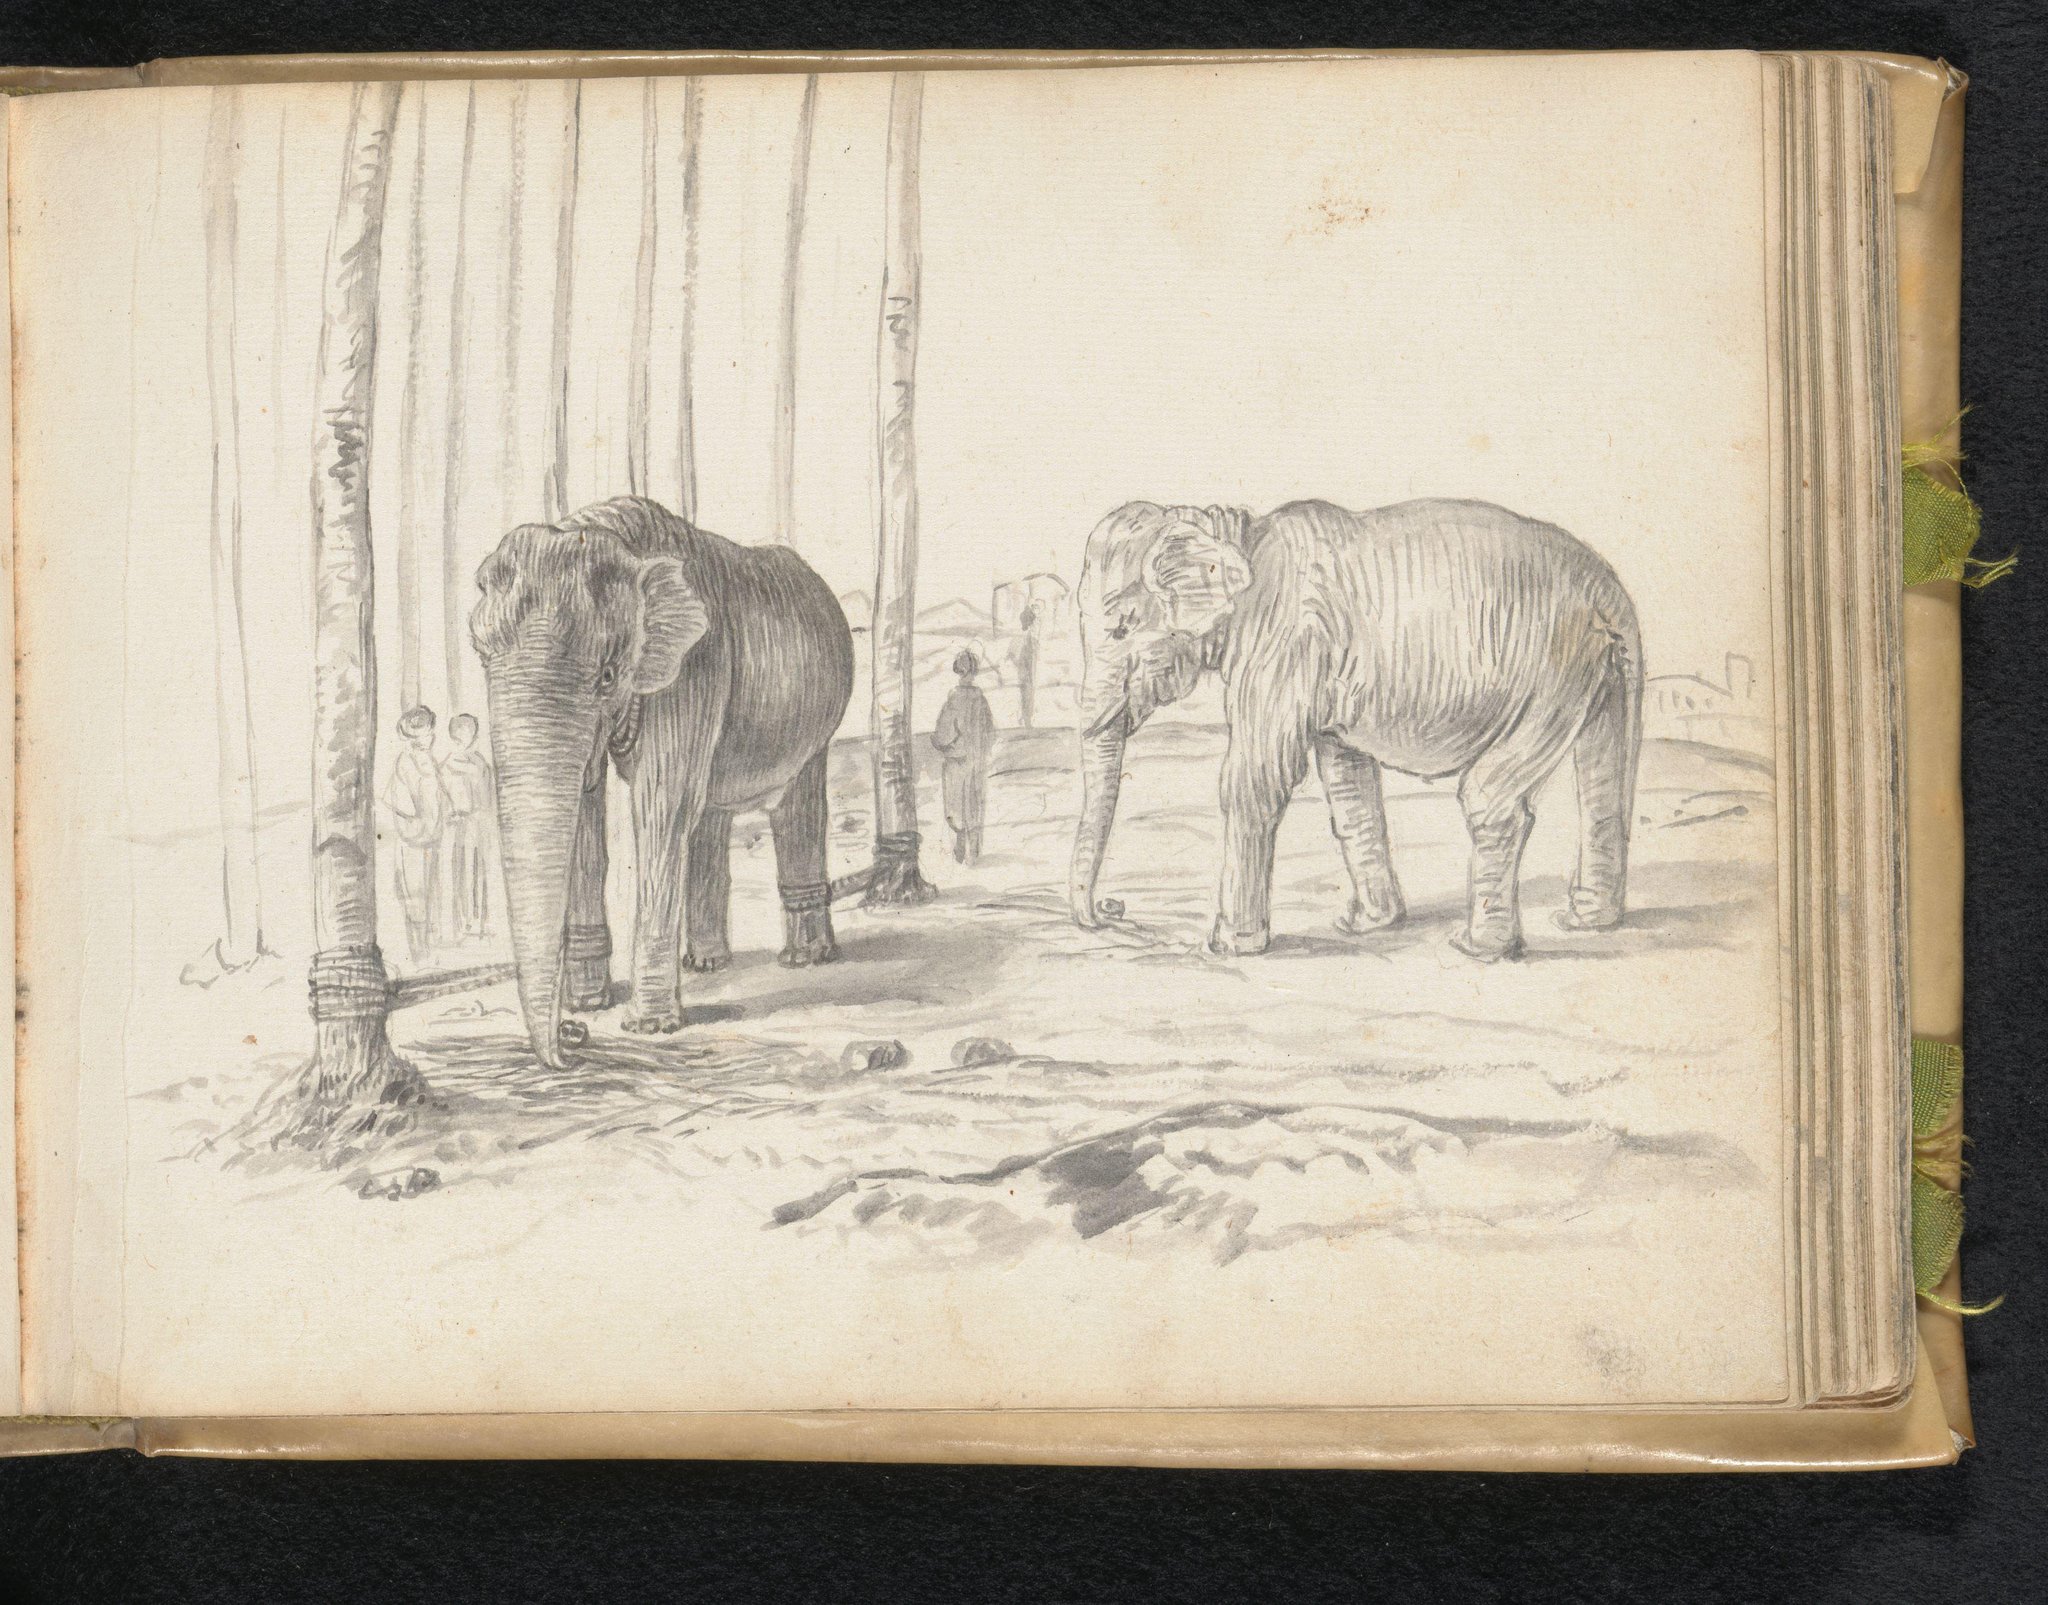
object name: sketchbook leaf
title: Two elephants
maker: esaias boursse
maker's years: 1631-1672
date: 1662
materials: ink, paper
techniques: brush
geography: sri lanka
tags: asiatic races and peoples (srilankans), trunked animals: elephant (+ man and animal), 41d232(...) skirt (lungi), taming, domestication of animals; tamed or domesticated animal, sri lanka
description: Op een open terrein, met rechts een tiental kokospalmbomen en op de achtergrond een vage schets van bebouwing staan twee Sri Lankaanse olifanten (Elephas maximus maximus). De olifant links is een mannetje of vrouwtje zonder slagtanden (aliya). Met touwen staat het dier vastgebonden tussen twee bomen: de rechtervoorpoot aan de boom voor hem en de linkerachterpoot aan de boom achter hem. Het is een fase in het proces van temmen. Met de slurf pakt het dier voer op dat voor hem is neergelegd. De tweede olifant, rechts in de tekening, zien we van zijn linkerkant. Dit mannetje met korte slagtanden (atha) is tam. Hij loopt los en speelt een rol bij het 'breken' van de vastgebonden olifant. Ook hij grijpt met zijn slurf naar voedsel op de grond voor hem. Links tussen de bomen en op de achtergrond midden zijn vaag een viertal figuren geschetst die toekijken, waarschijnlijk mannen. Ze dragen een lang heupkleed (veshti, lungi), een bloes of doek om hun bovenlijf. Blad 56 uit een schetsboek met 117 bladen.